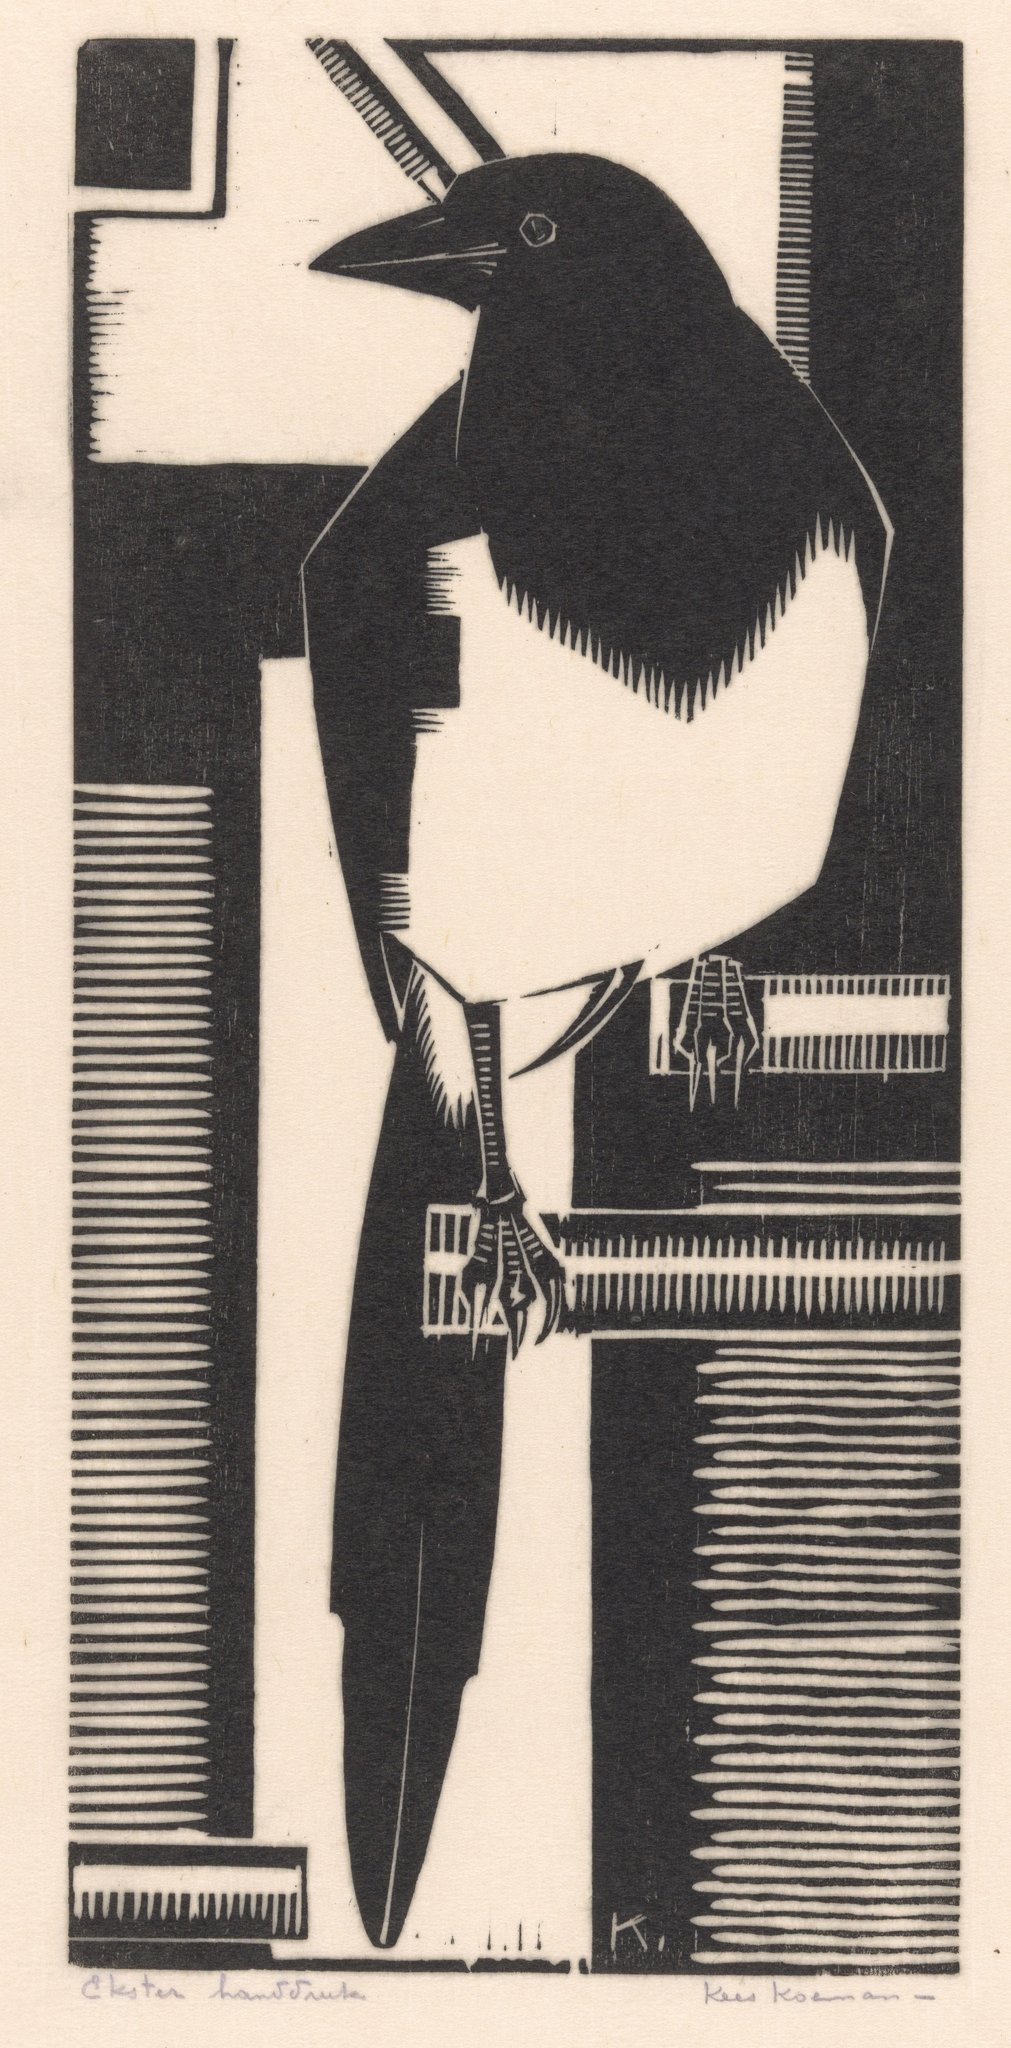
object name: print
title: Ekster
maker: kees koeman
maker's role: print maker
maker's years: 1895-1954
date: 1910-1932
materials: paper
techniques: woodcut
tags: song-birds: magpie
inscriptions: collector's mark: Lugt 2228